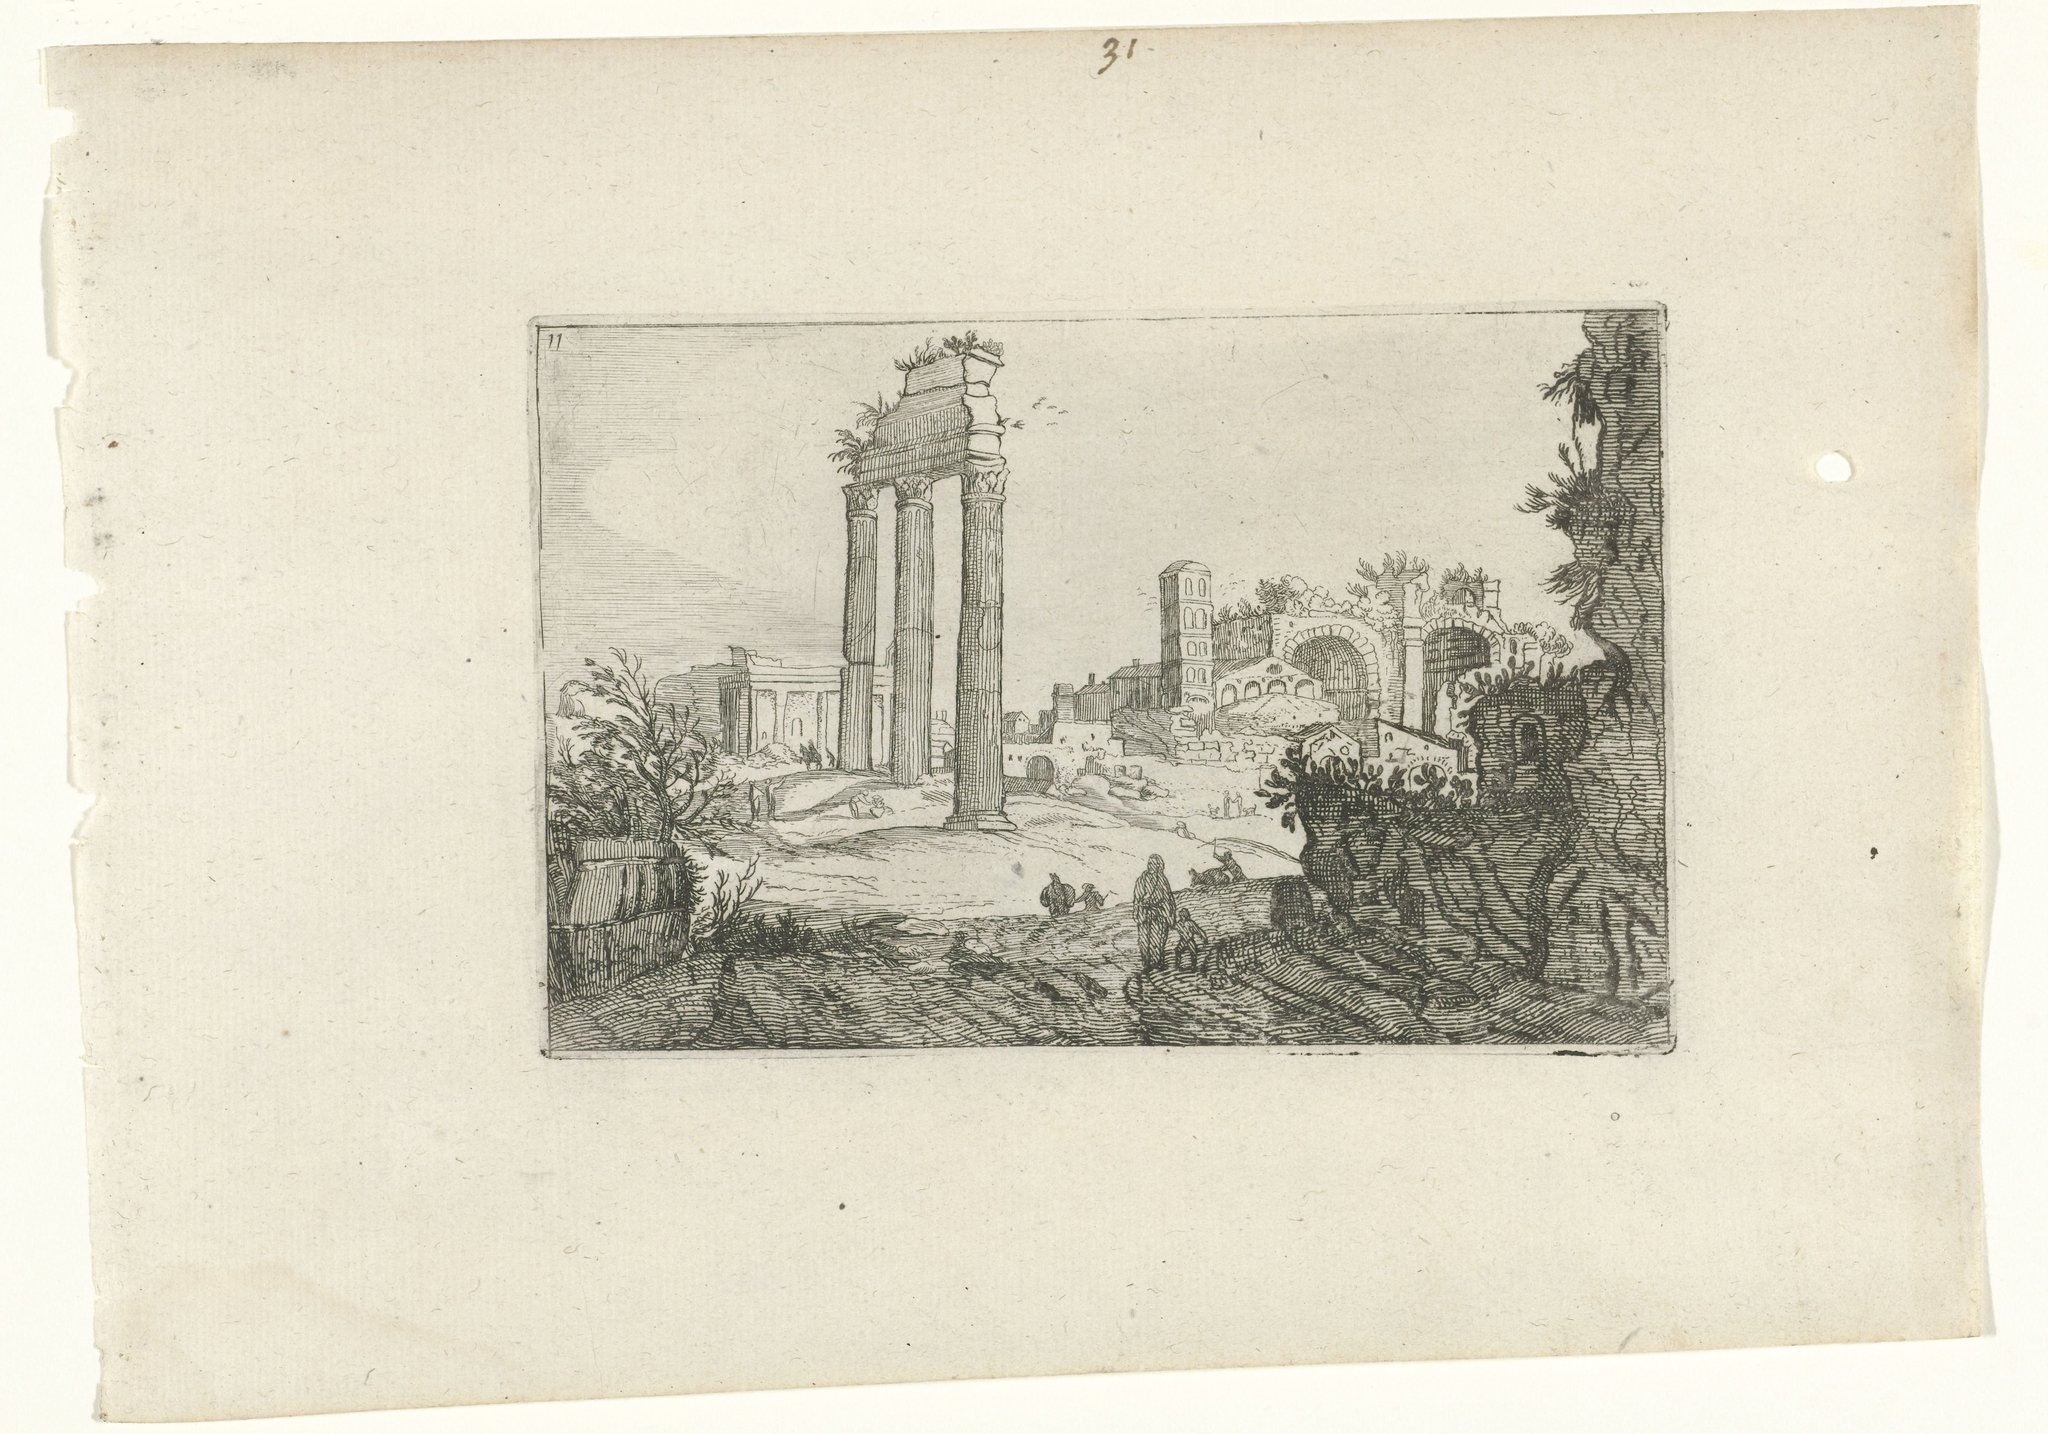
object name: print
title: Tempel van Castor en Pollux en de basilica van Constantijn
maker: Anonymous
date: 1594-1685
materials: paper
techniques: etching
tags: landscape with ruins, rome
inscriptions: inscription: ‘31’, collector's mark: Lugt 2760, collector's mark: Lugt 2228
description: Links de drie zuilen van de tempel van Castor en Pollux en rechts de basilica van Constantijn op het Forum Romanum in Rome. Op de voorgrond enkele figuren. Prent maakt deel uit van een serie Romeinse ruïnes en kustlandschappen naar prenten van Willem van Nieulandt. Deze serie is een kopie van de serie, die Claes Jansz Visscher naar Van Nieulandt maakte.